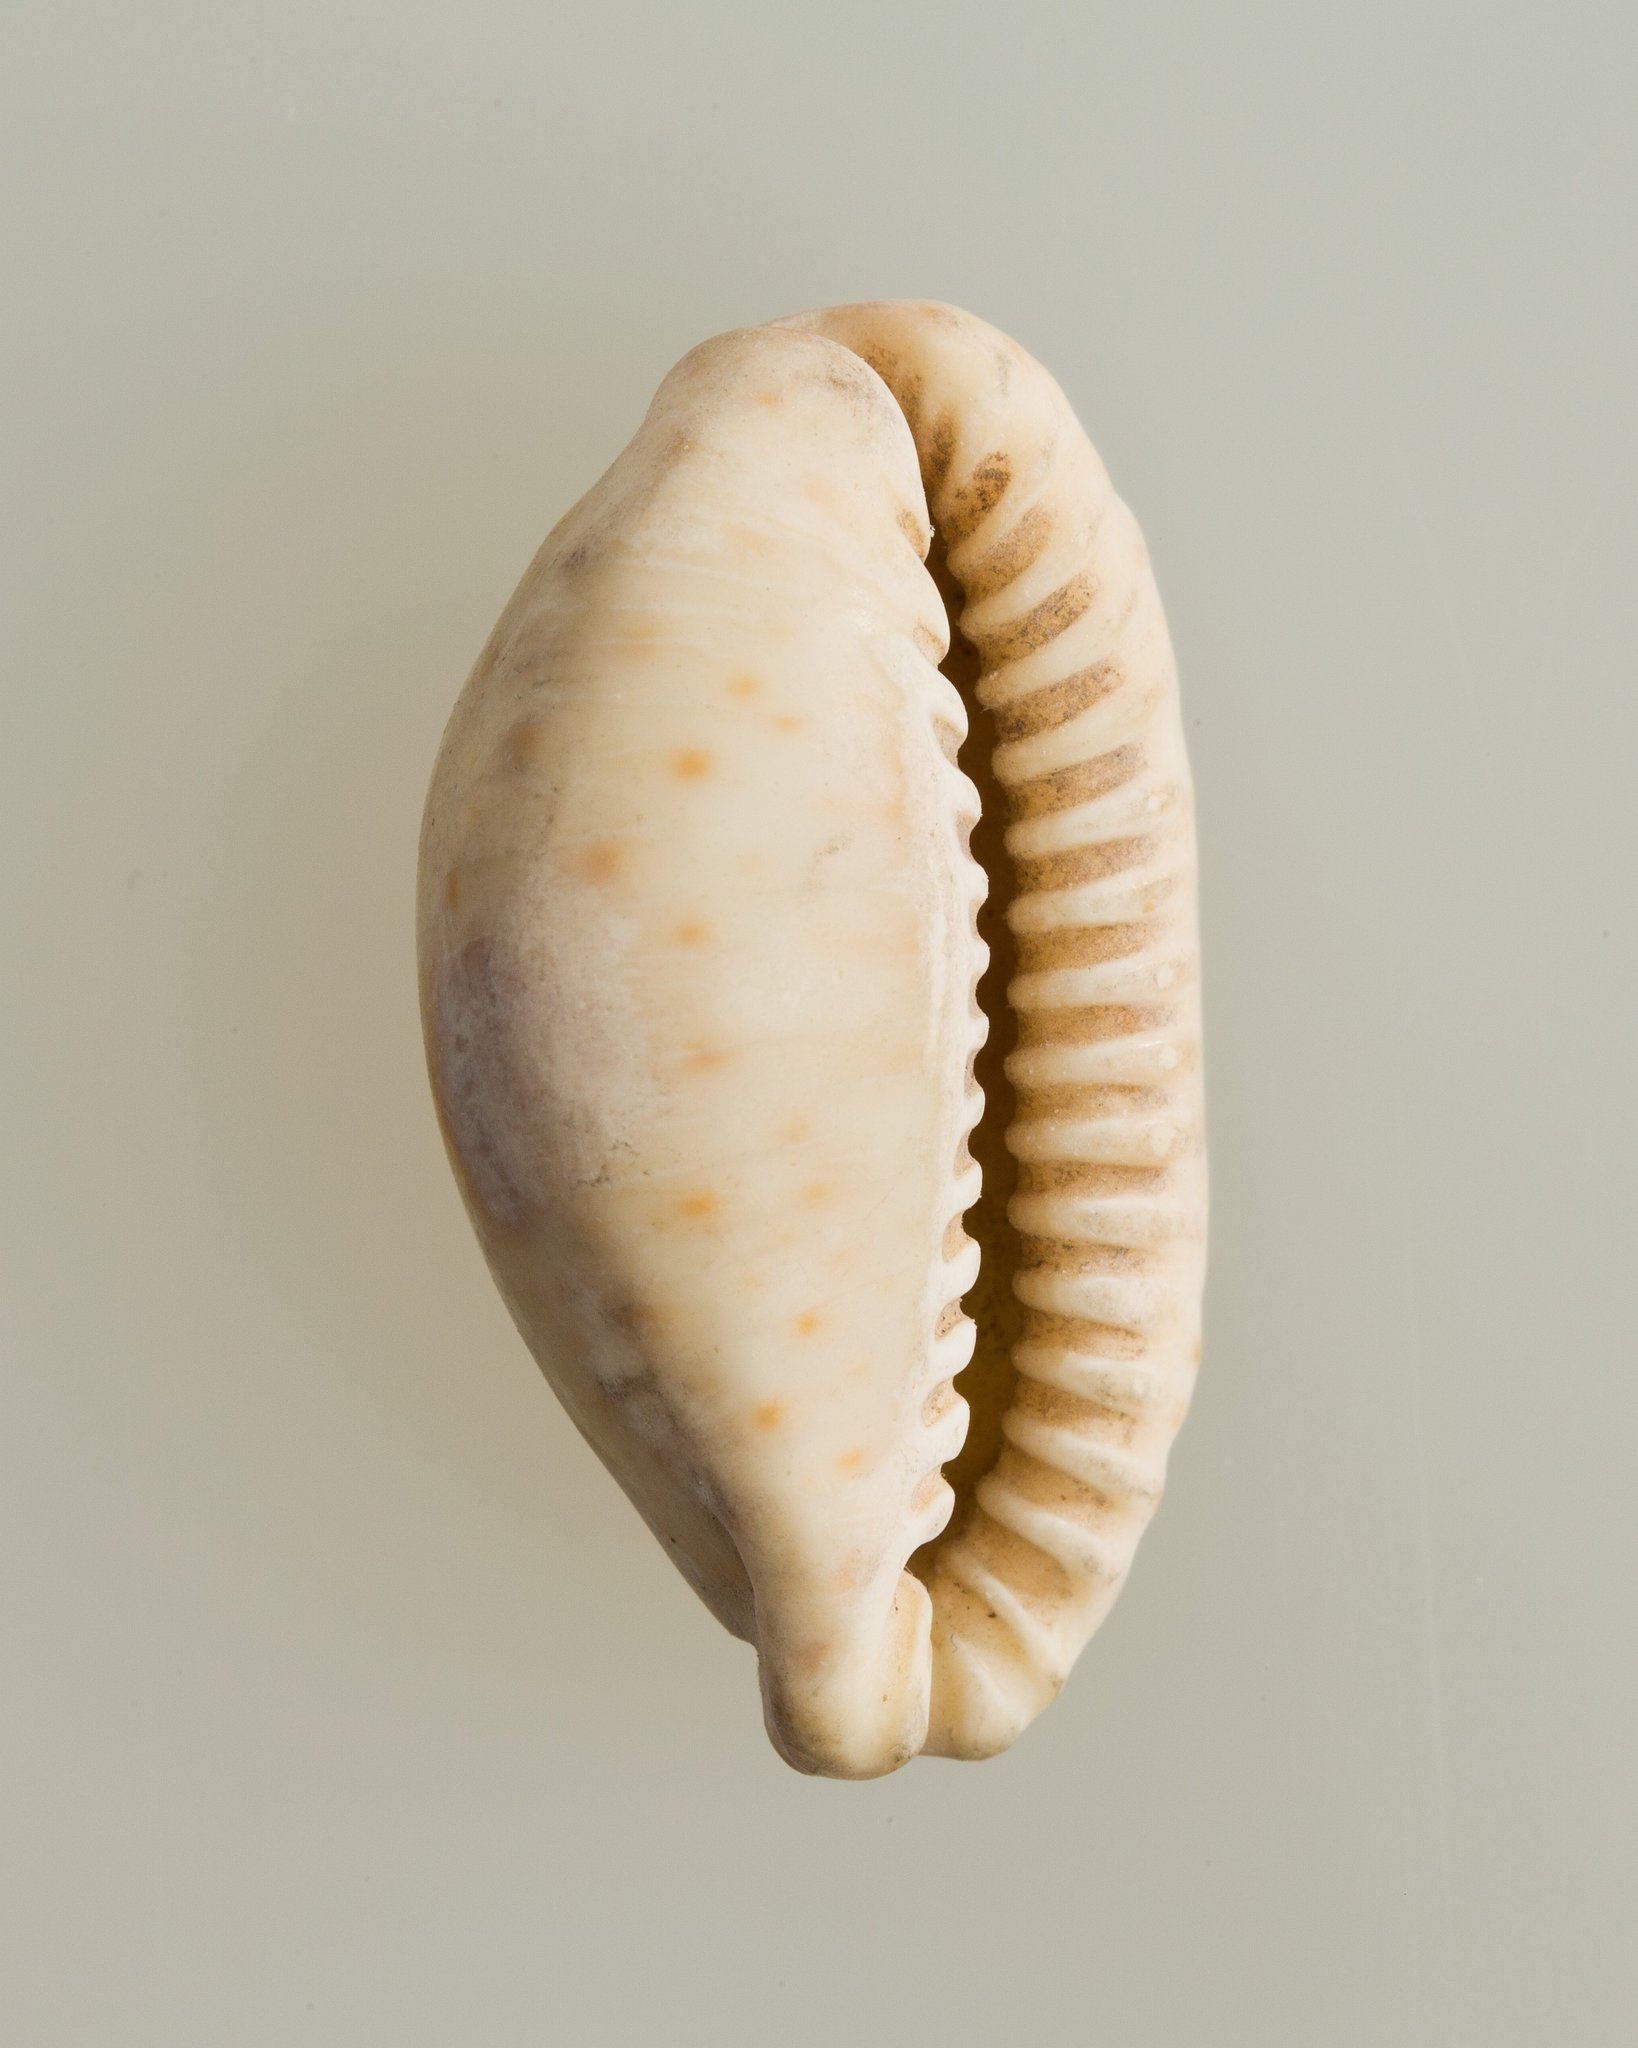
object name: pendant, shell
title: Shell pendant or bead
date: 3850-2960 BCE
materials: shell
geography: egypt